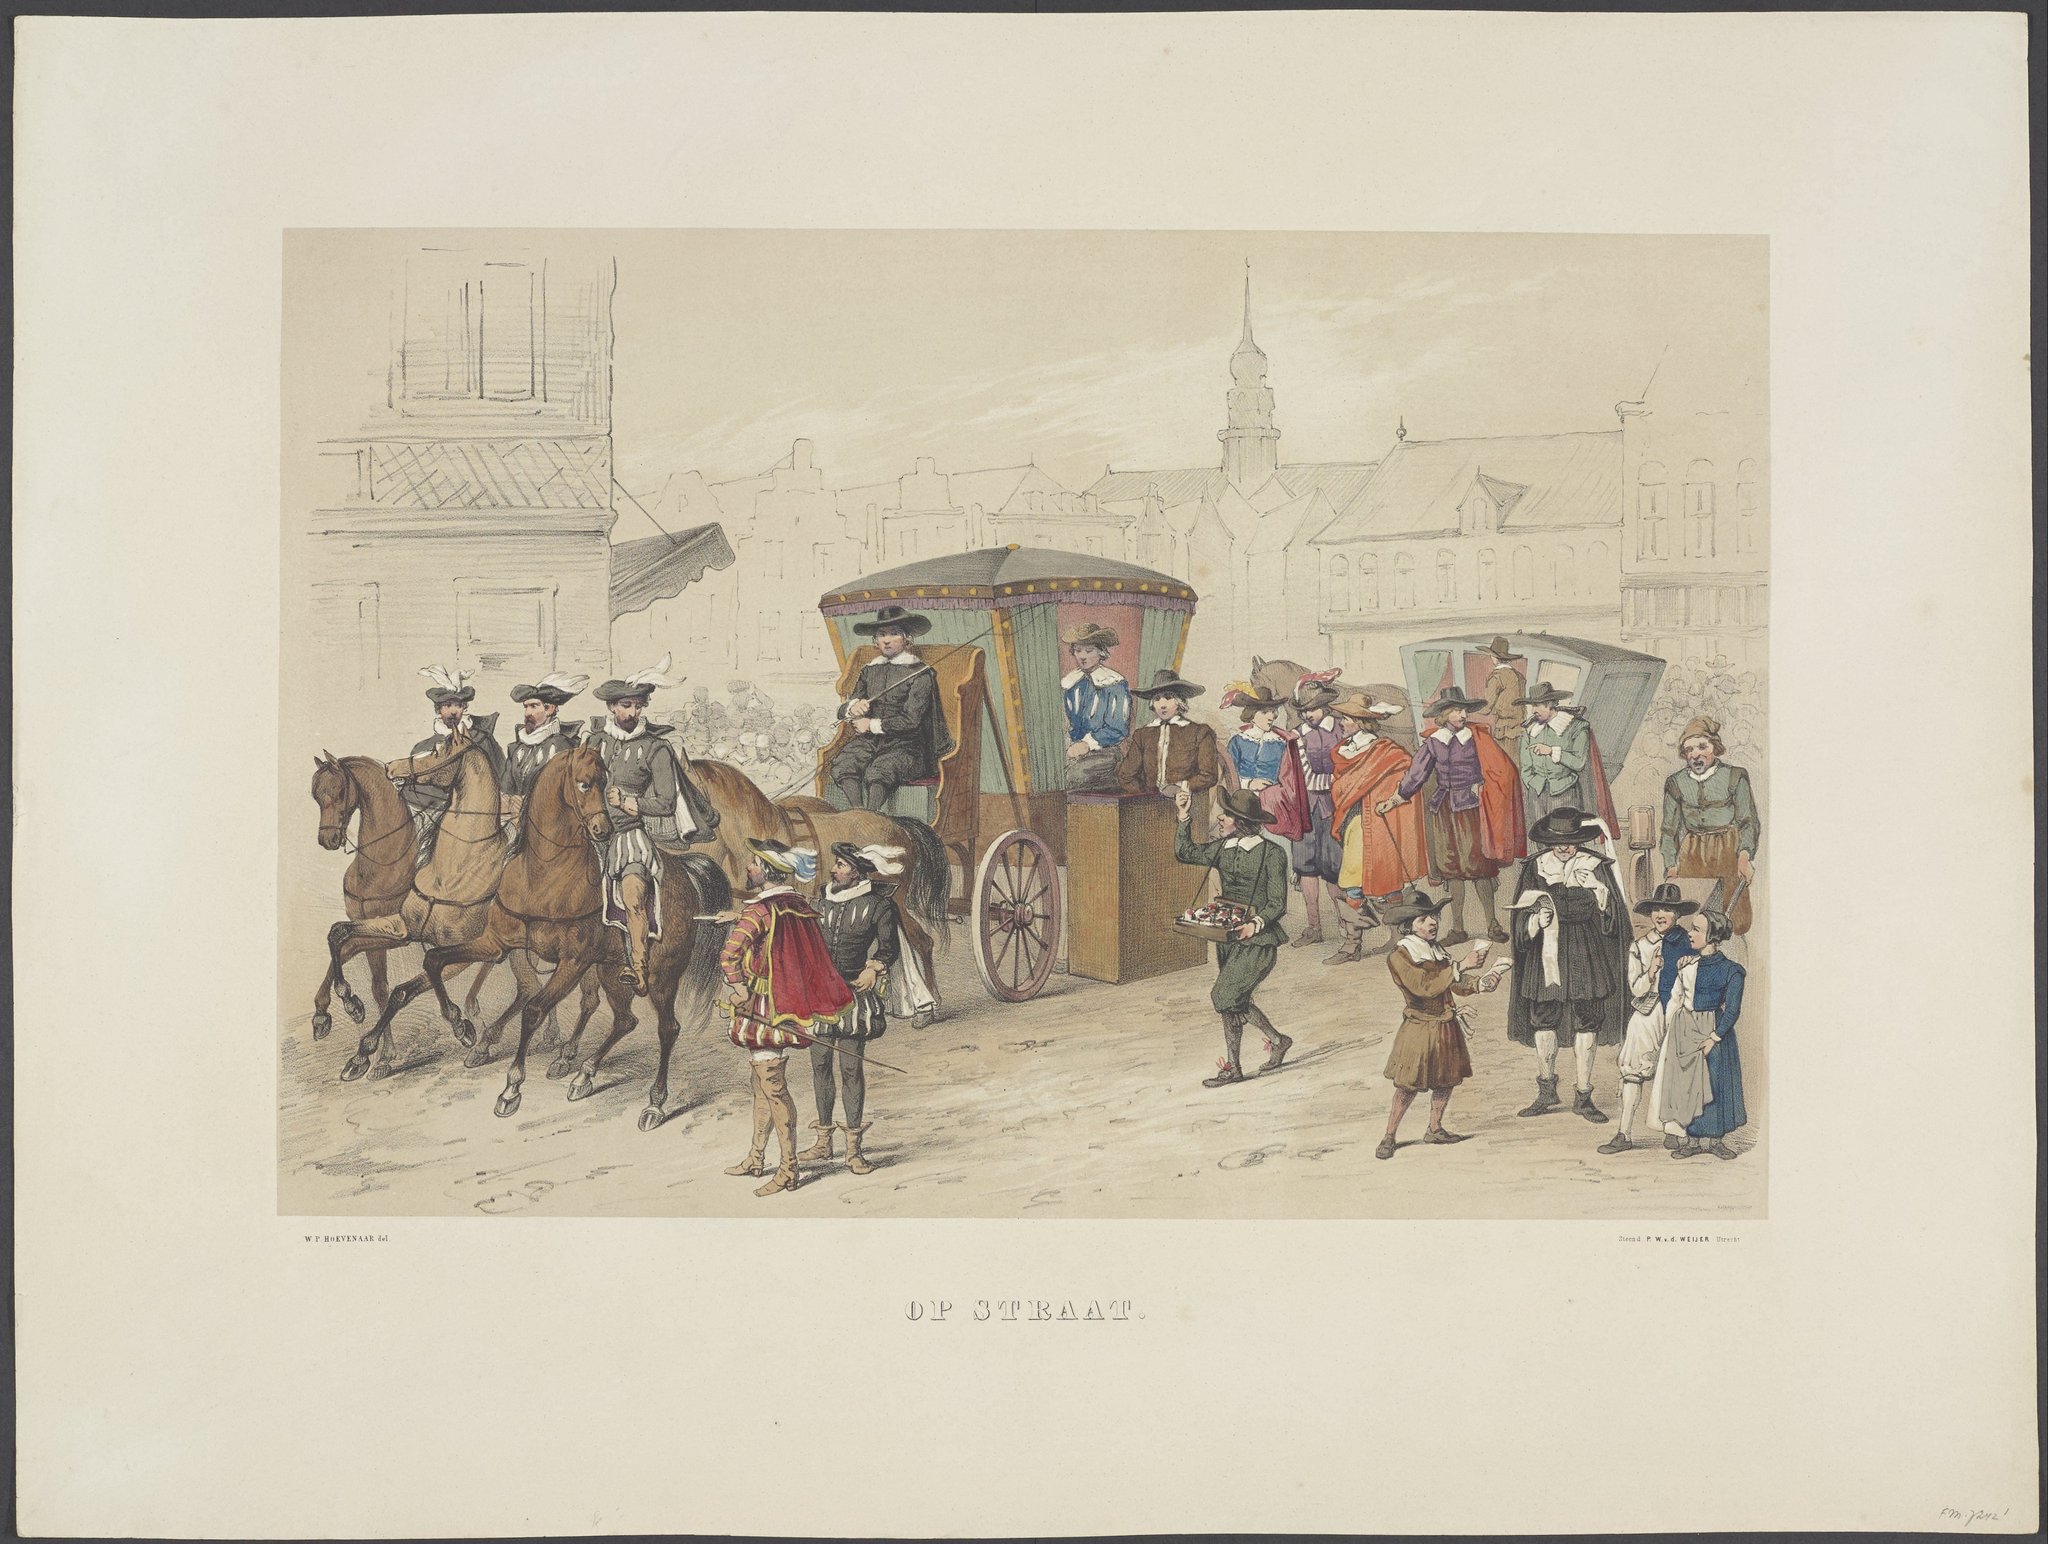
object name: print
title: Utrechtse maskerade van 1856, plaat 1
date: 1856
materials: paper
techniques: hand coloring, lithograph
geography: utrecht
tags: students' pageant, costumes used in pageants, utrecht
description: Op een plein rijden twee koetsen getrokken door paarden. Rondom staan burgers van verschillende rangen. Onderdeel van de groep van zeven platen met verklaring van de historische optocht in maskerade opgevoerd door de studenten van de vereniging Mutua Fides van de Utrechtse Hogeschool op 25 juni 1856 ter gelegenheid van de viering van haar 220-jarige bestaan.